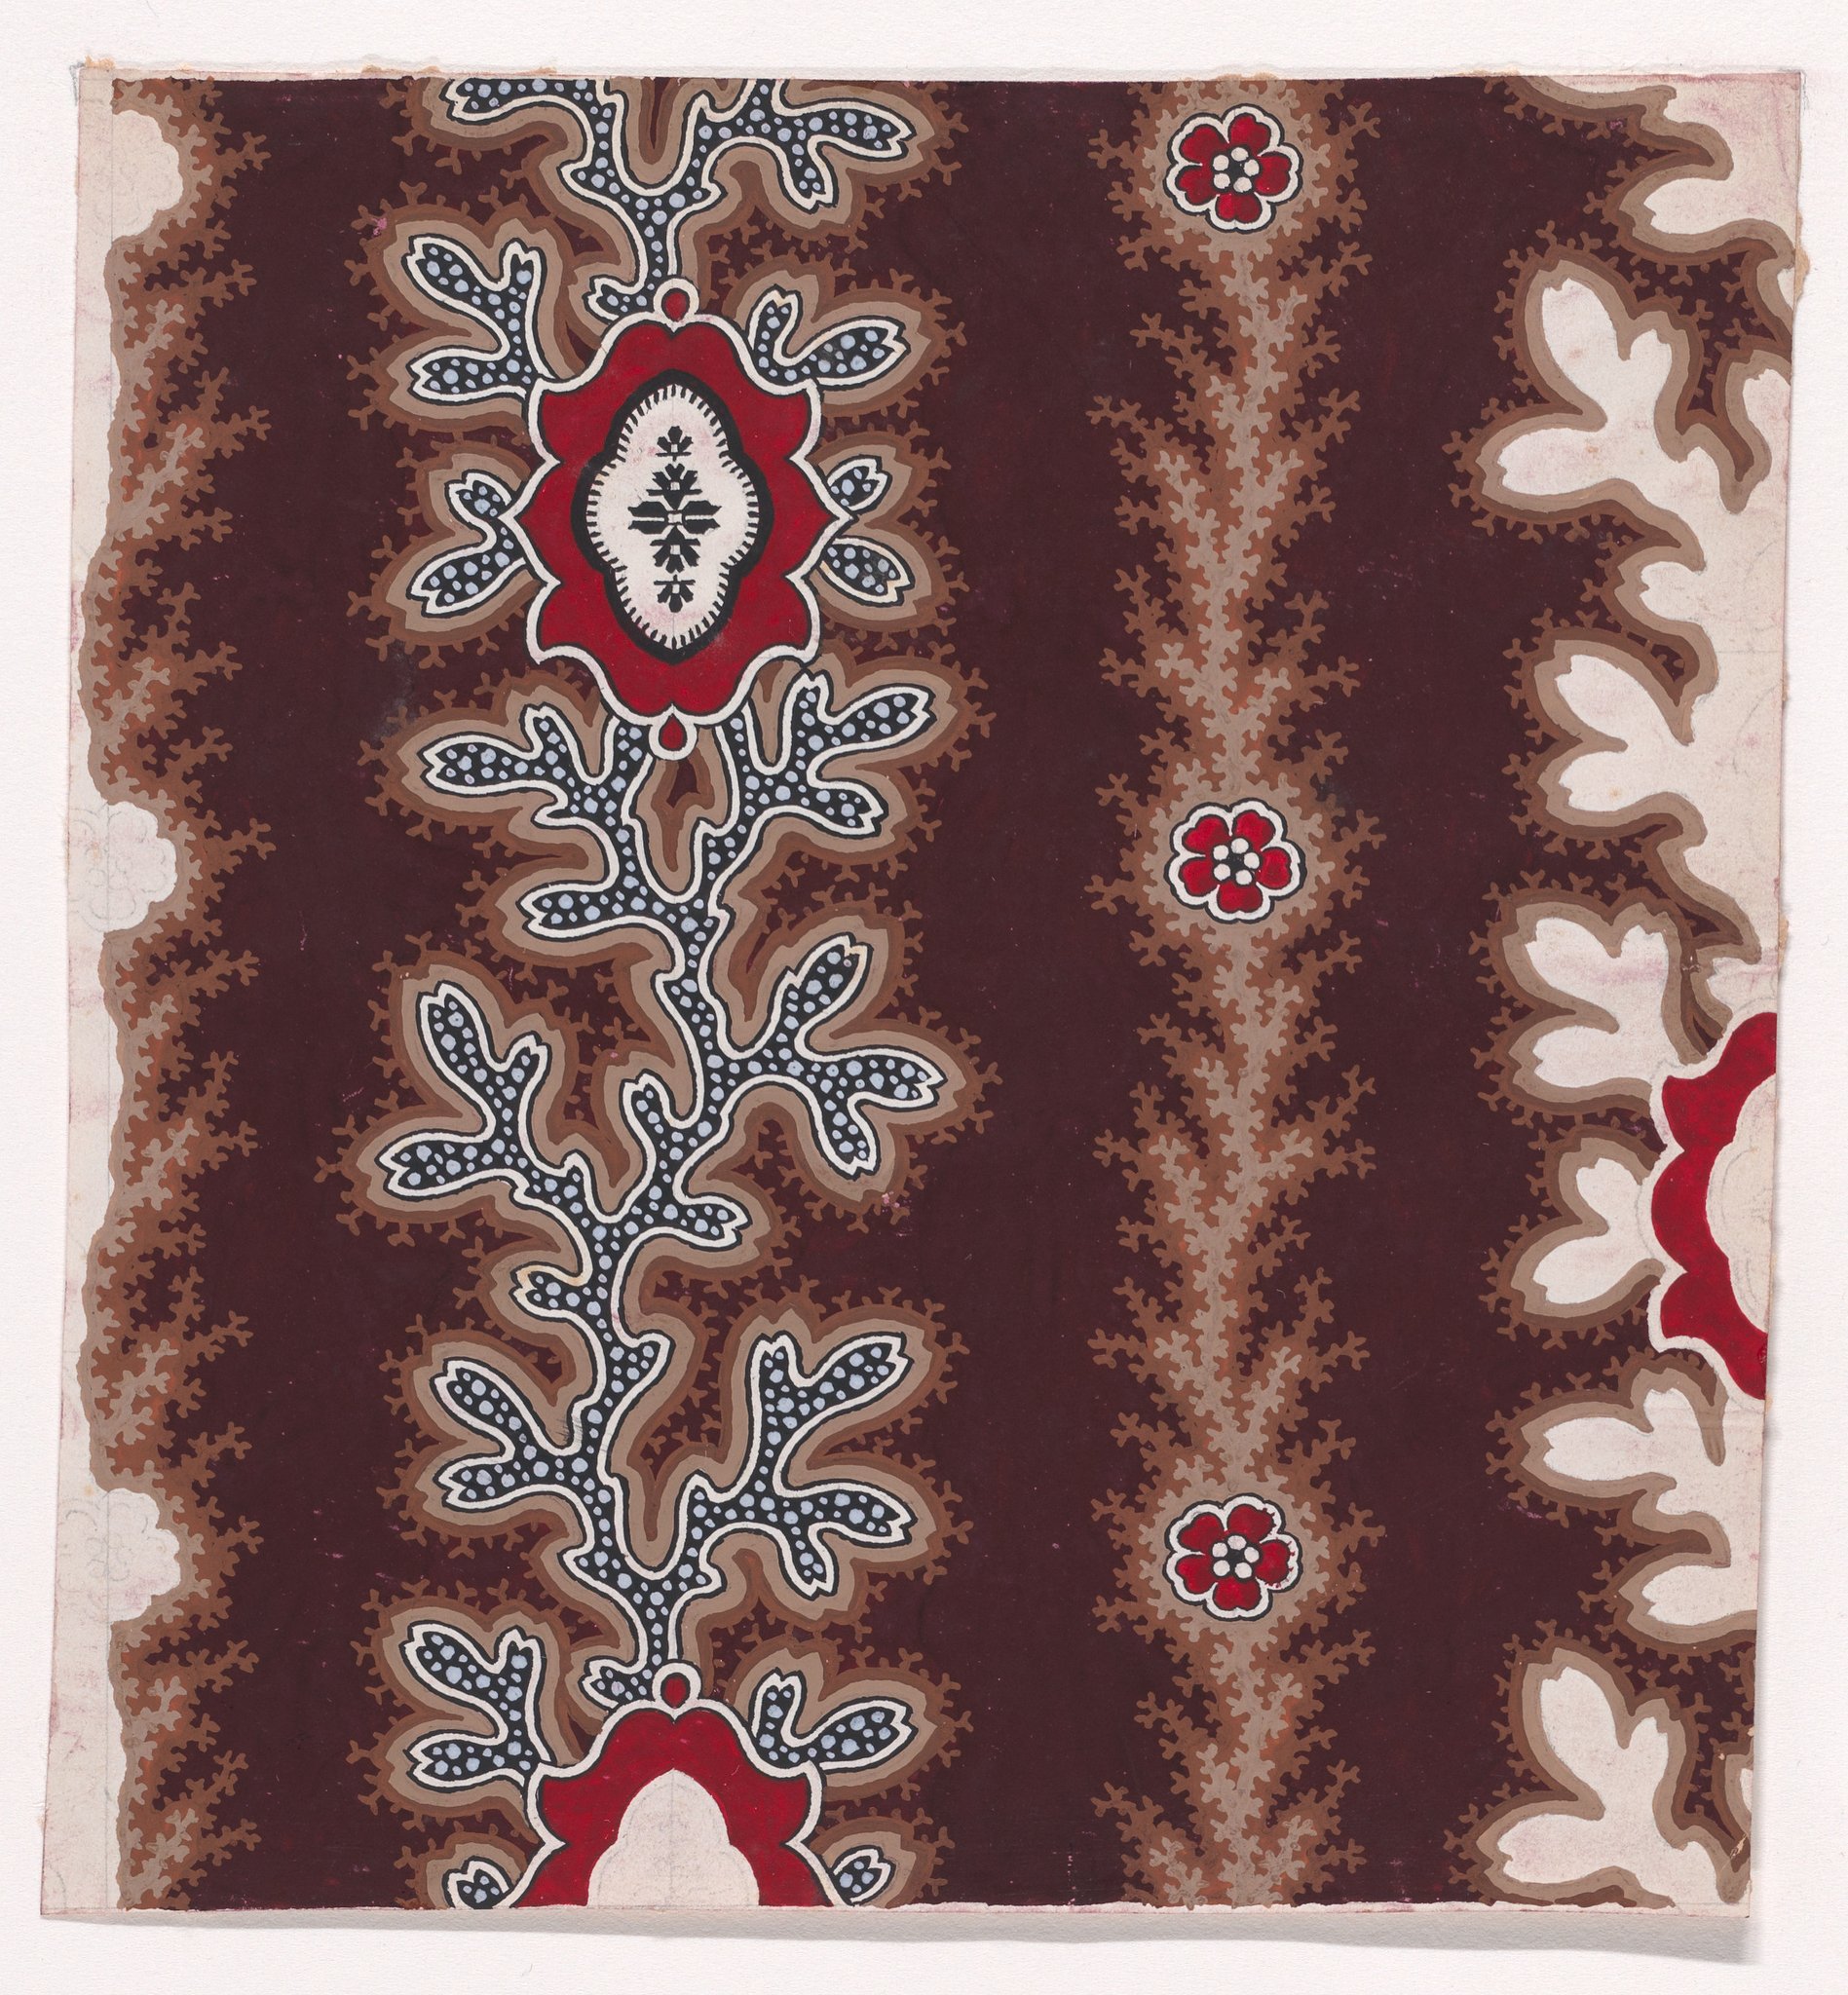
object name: drawing ornament architecture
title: Textile Design with Alternating Vertical Garlands of Stylized Leaves and Branches Decorated with Quatrefoils with an Ornamental Frame and Rosettes with Pearls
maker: anonymous, alsatian, 19th century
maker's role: artist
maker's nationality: alsatian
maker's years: 1800-1900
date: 1840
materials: gouache